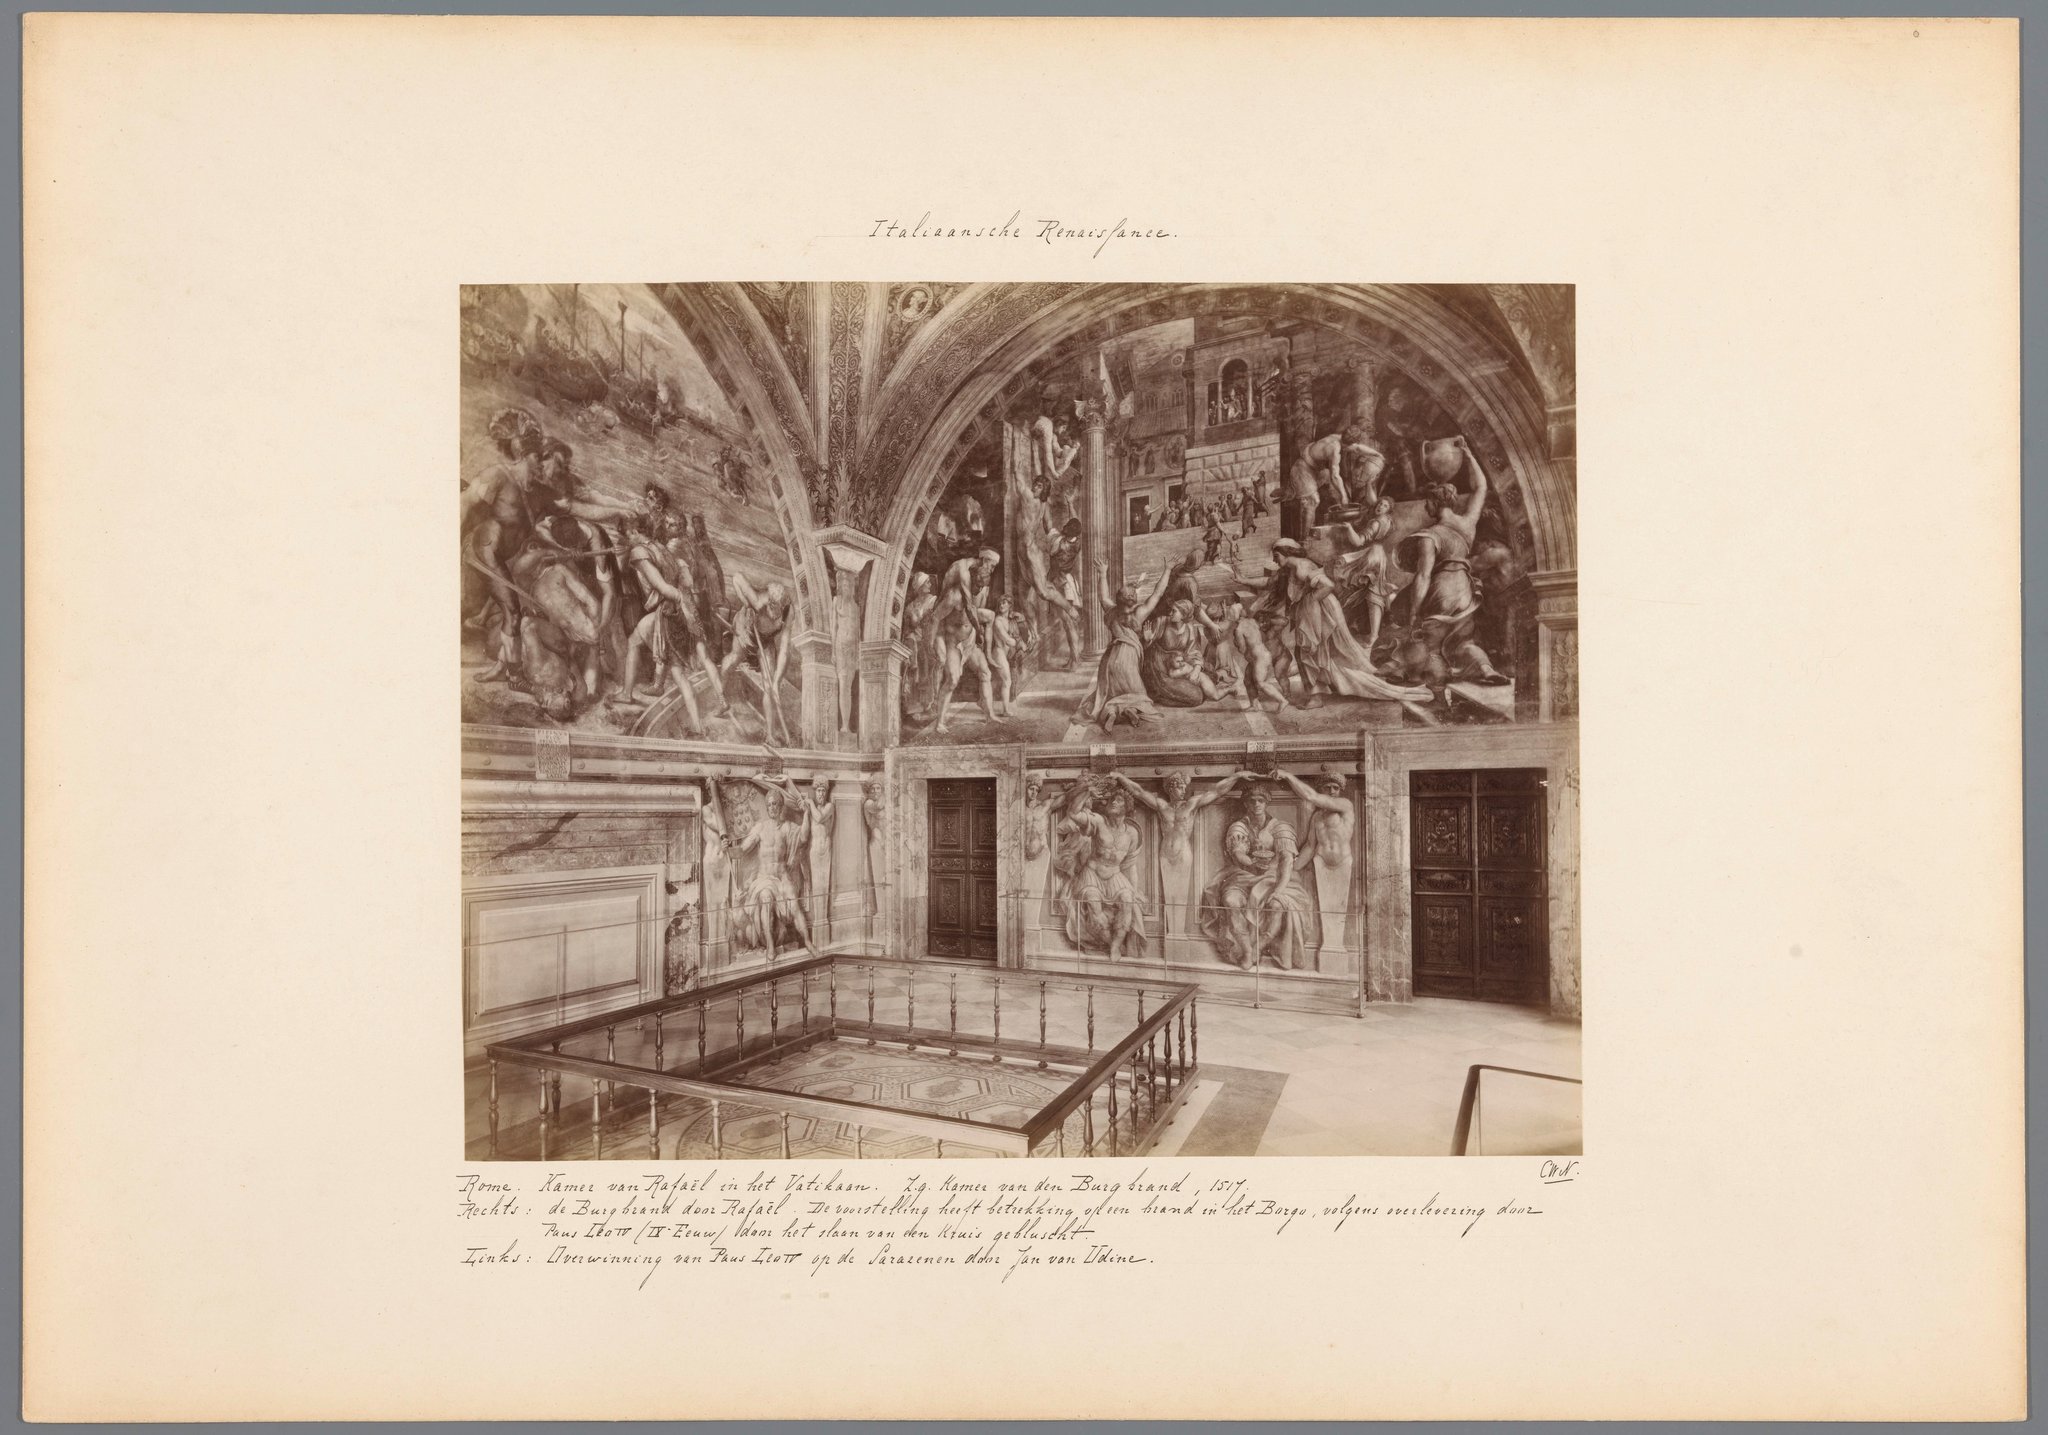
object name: photograph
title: Rome. Kamer van Rafaël in het Vatikaan. Z.g. Kamer van den Burgbrand, 1517.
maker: Anonymous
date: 1875-1900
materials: cardboard, photographic support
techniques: albumen print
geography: apostolisch paleis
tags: painting (including book-illumination, miniature-painting) (+ plaster ~ arts), palace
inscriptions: collector's mark: ‘INSTITUUT VOOR KUNST-NIJVERHEIDSONDERWIJS GABRIËL METSUSTRAAT No. 16 AMSTERDAM’, inscription: ‘Italiaansche Renaissance.’, collector's mark: ‘KUNSTNIJVERHEIDSCHOOL QUELLINUS AMSTERDAM FRANS HALSSTRAAT 14.’, inscription: ‘CWN.’